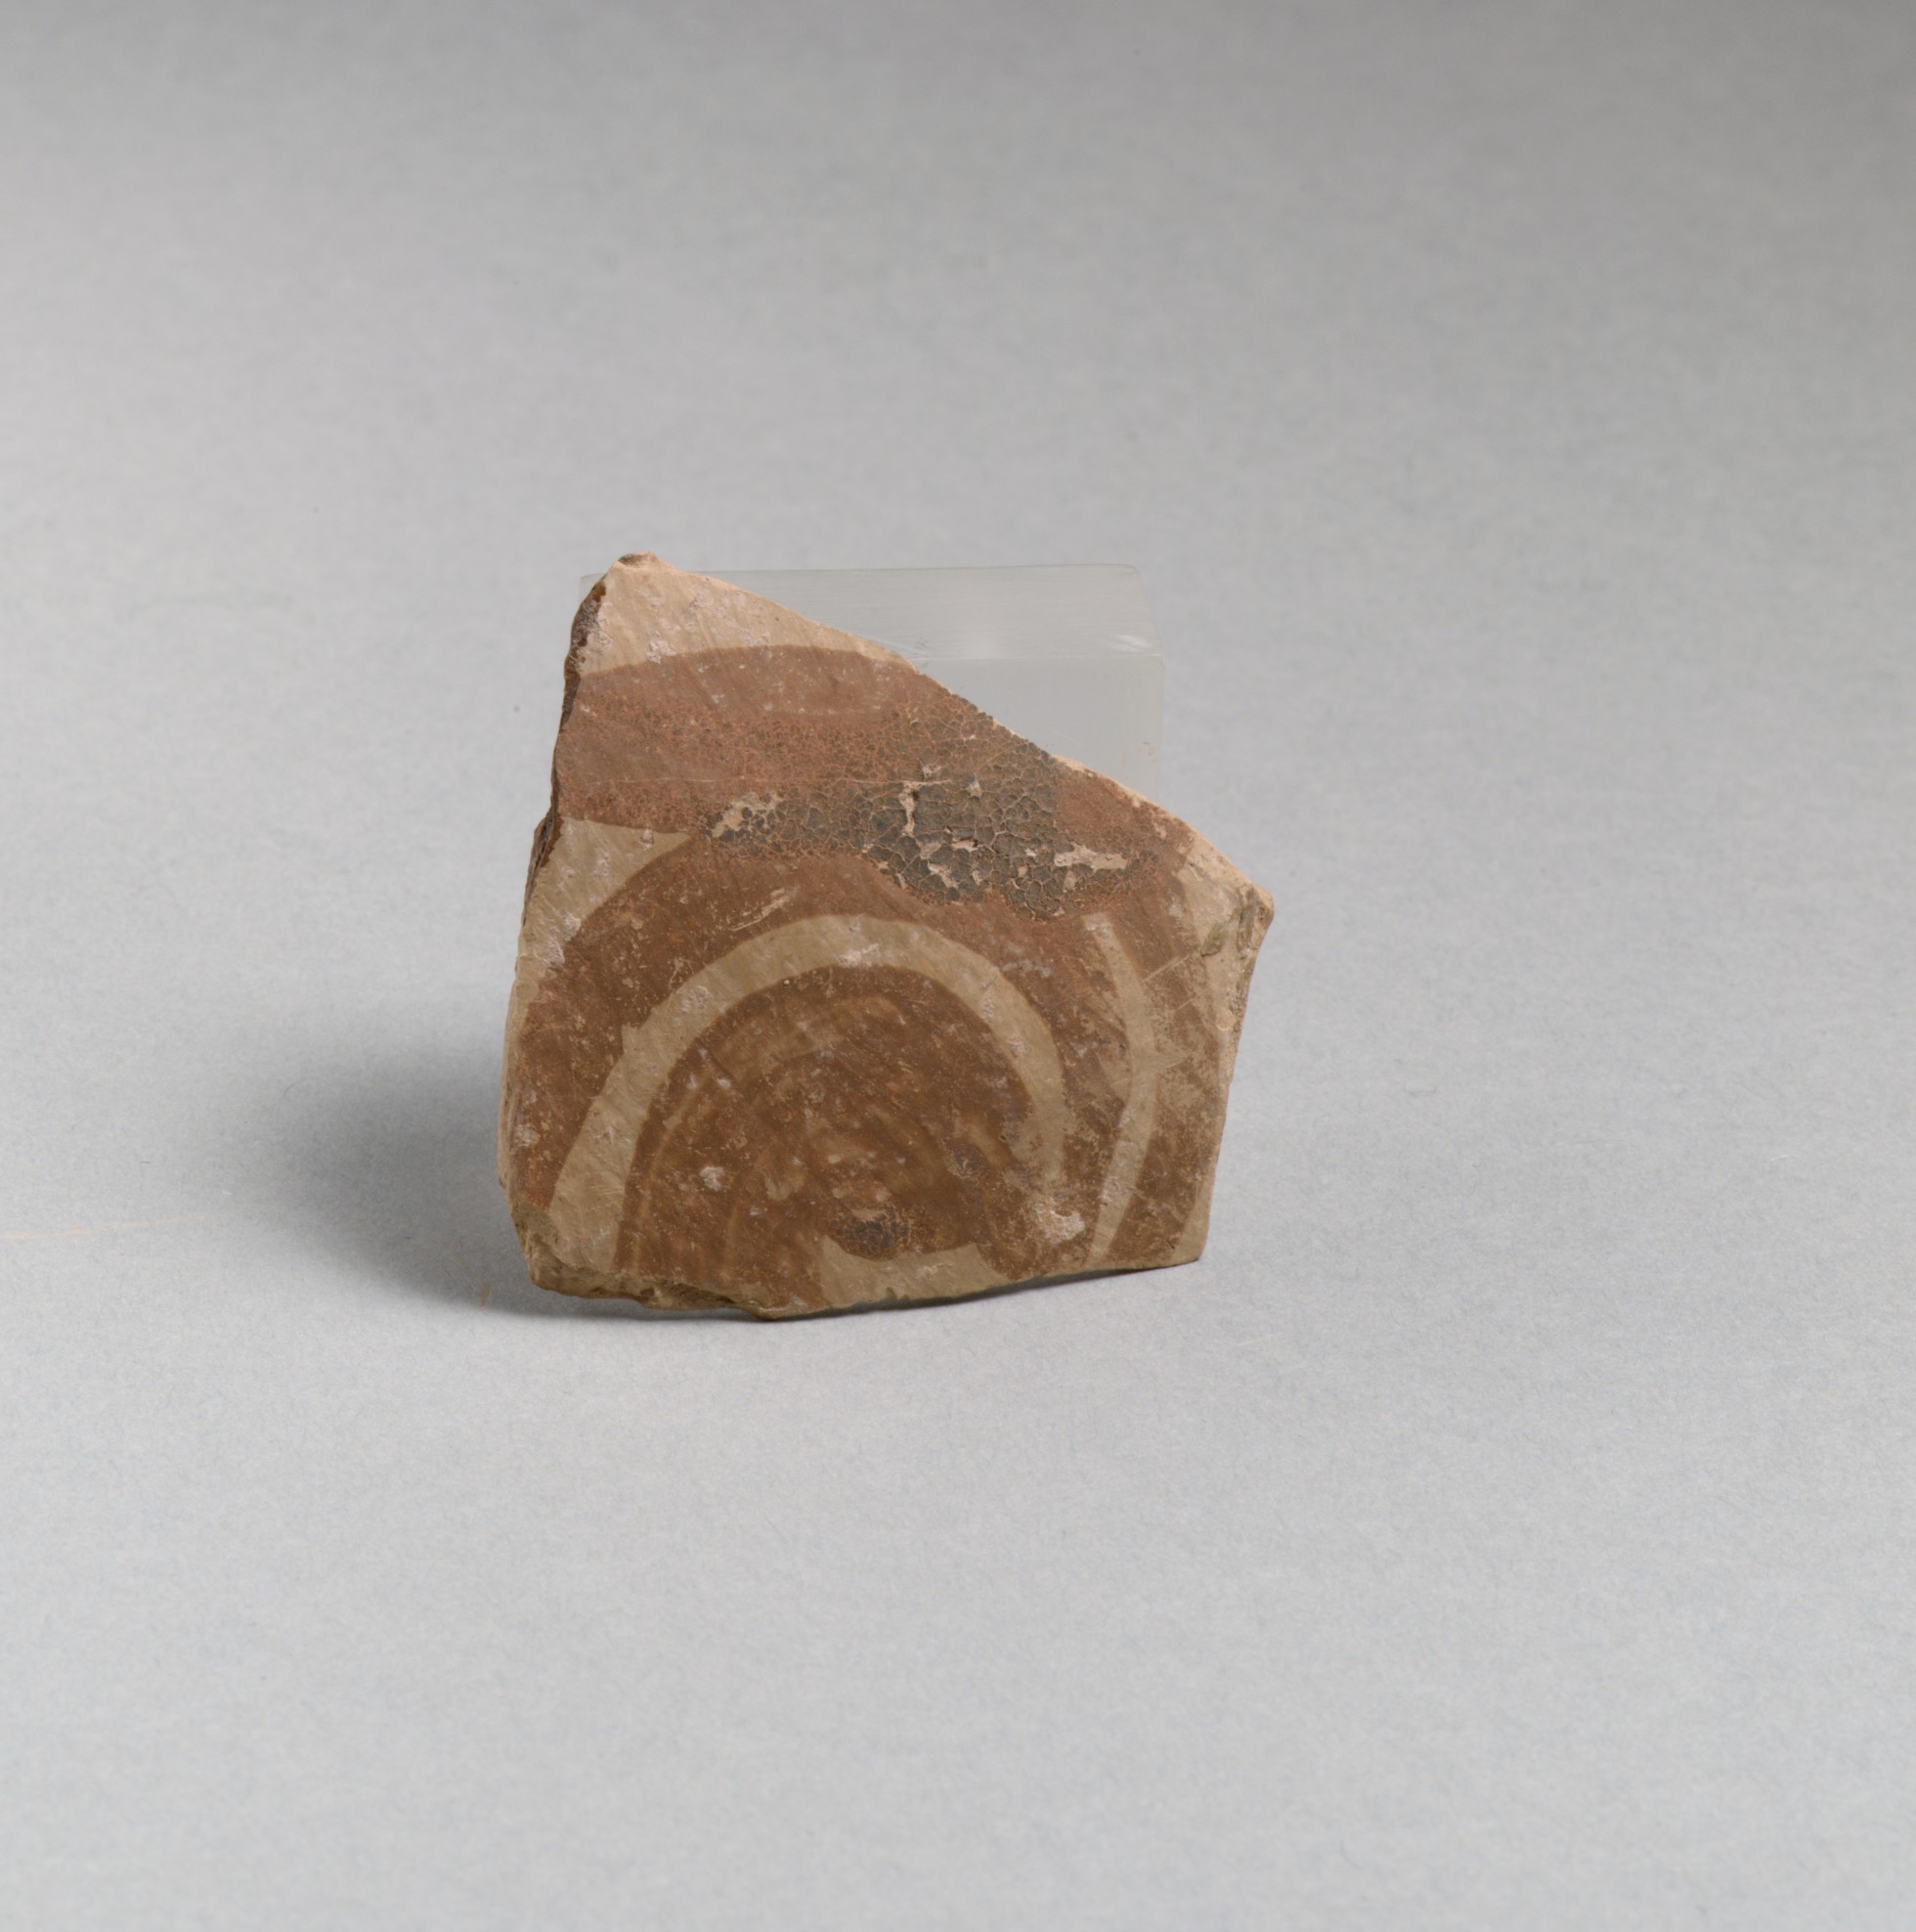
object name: vase fragment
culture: minoan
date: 1600-1450 BCE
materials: terracotta